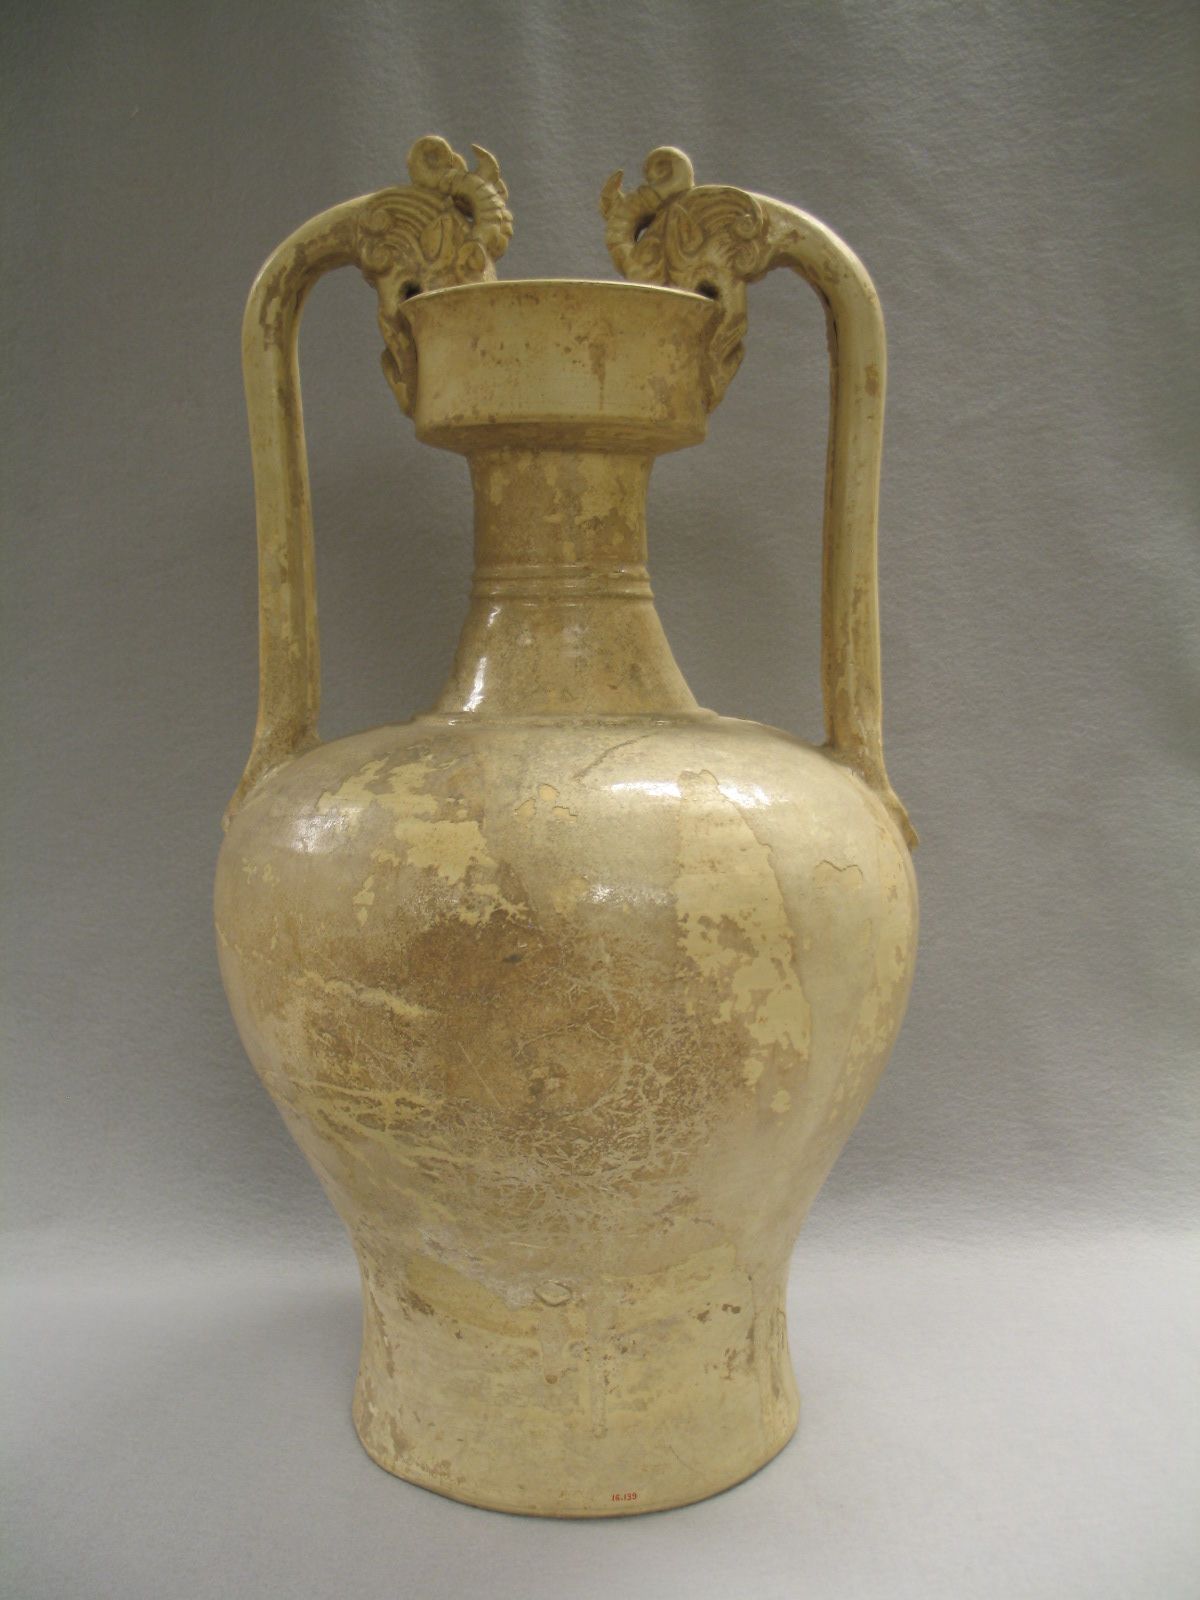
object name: jar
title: Jar with dragon-shaped handles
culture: chinese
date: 701-800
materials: glaze, stoneware